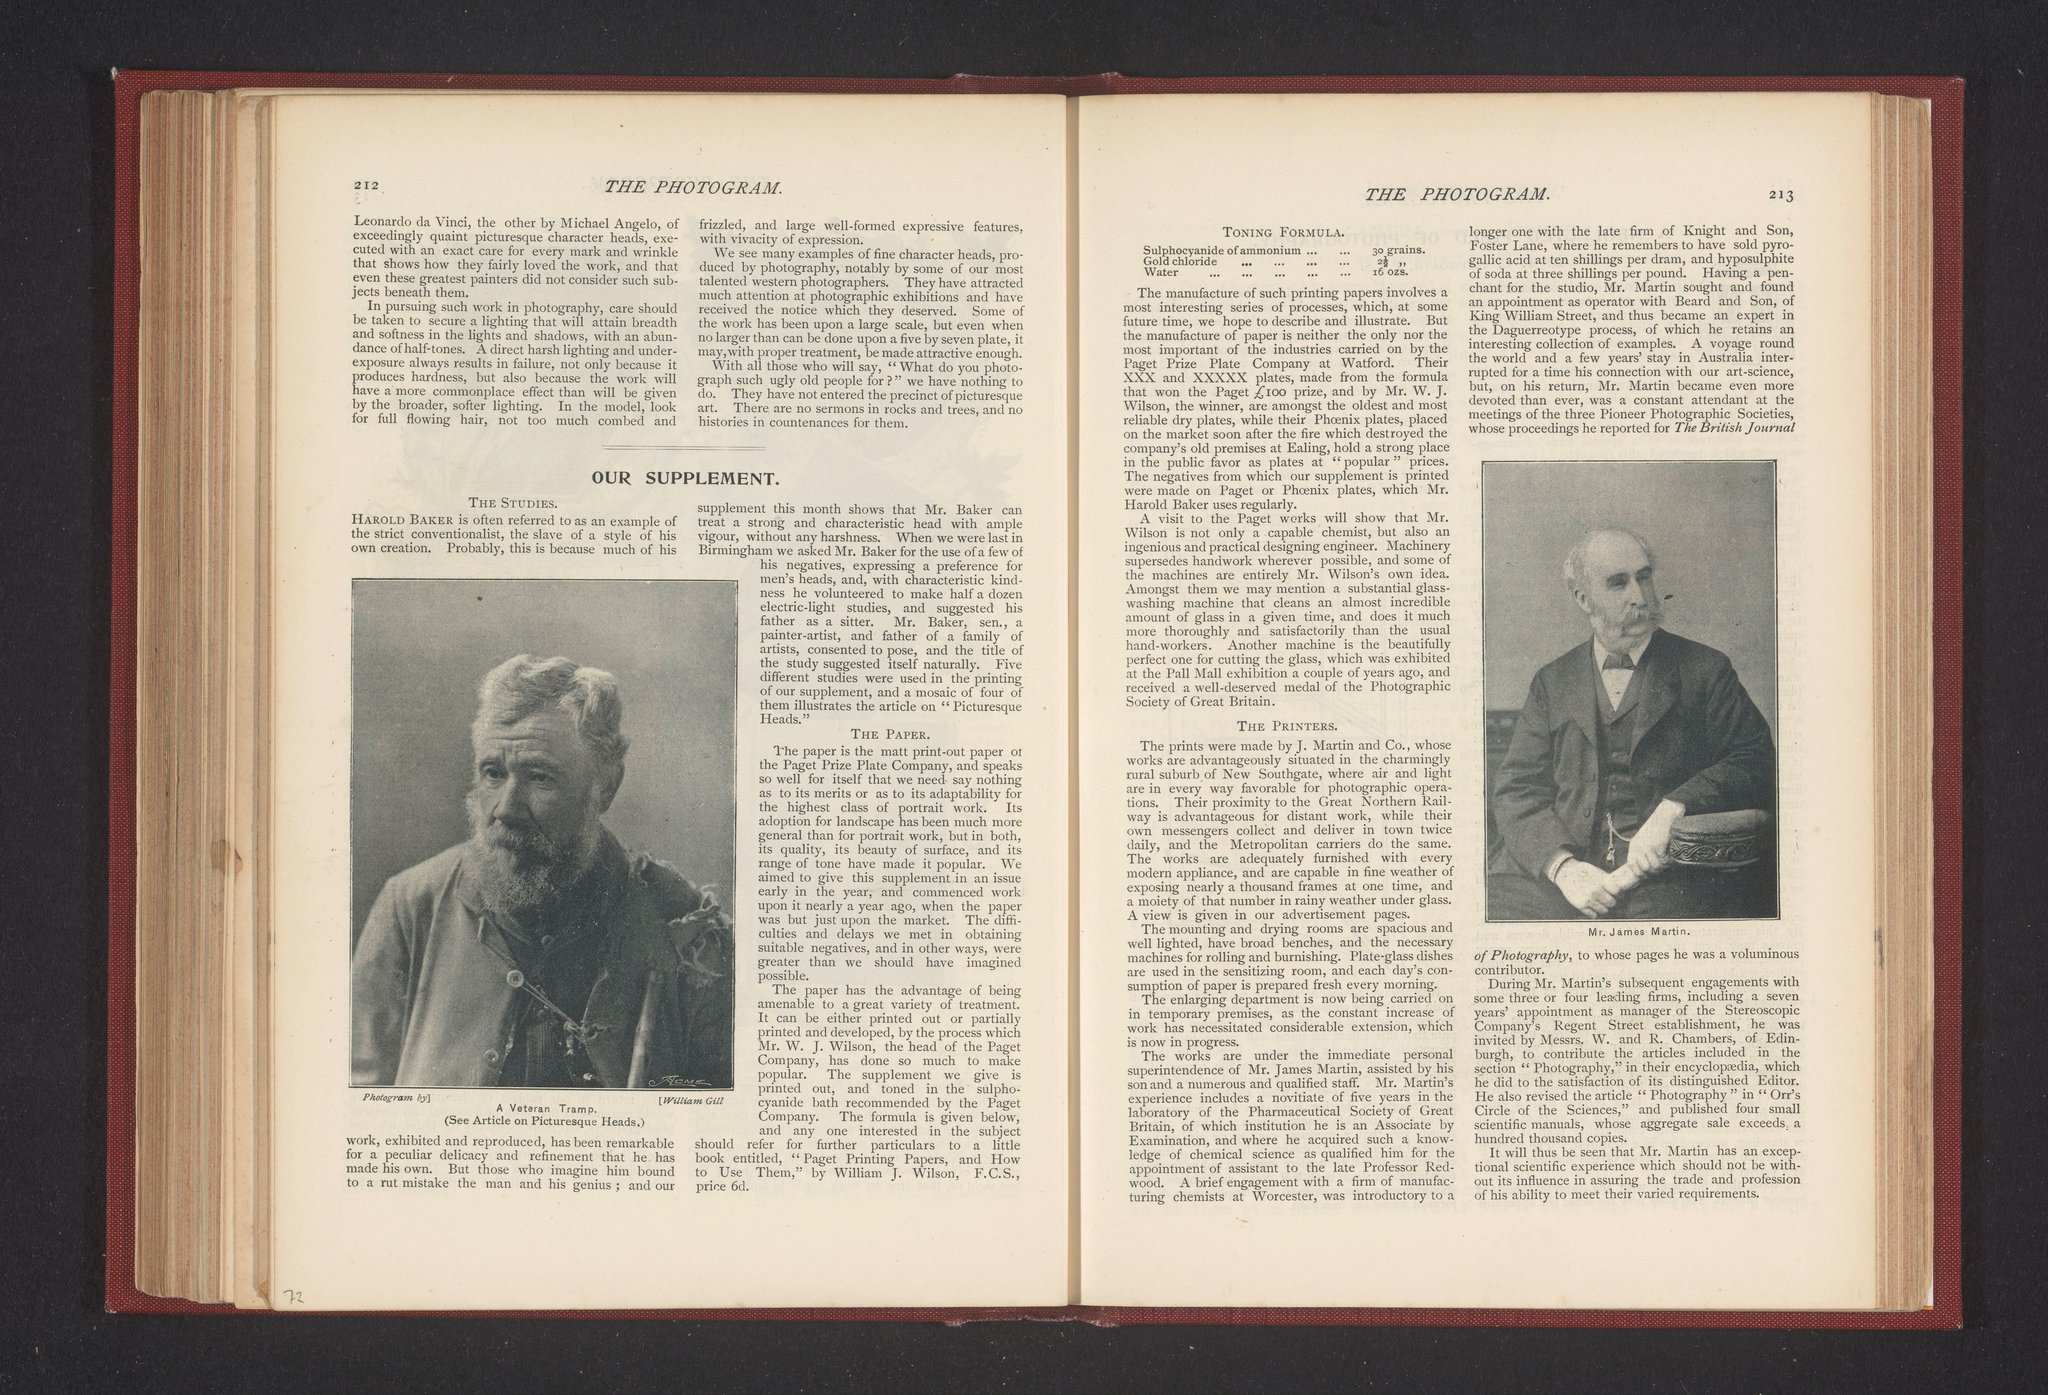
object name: photomechanical print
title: Mr. James Martin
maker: Anonymous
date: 1889-1894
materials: paper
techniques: autotype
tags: historical persons